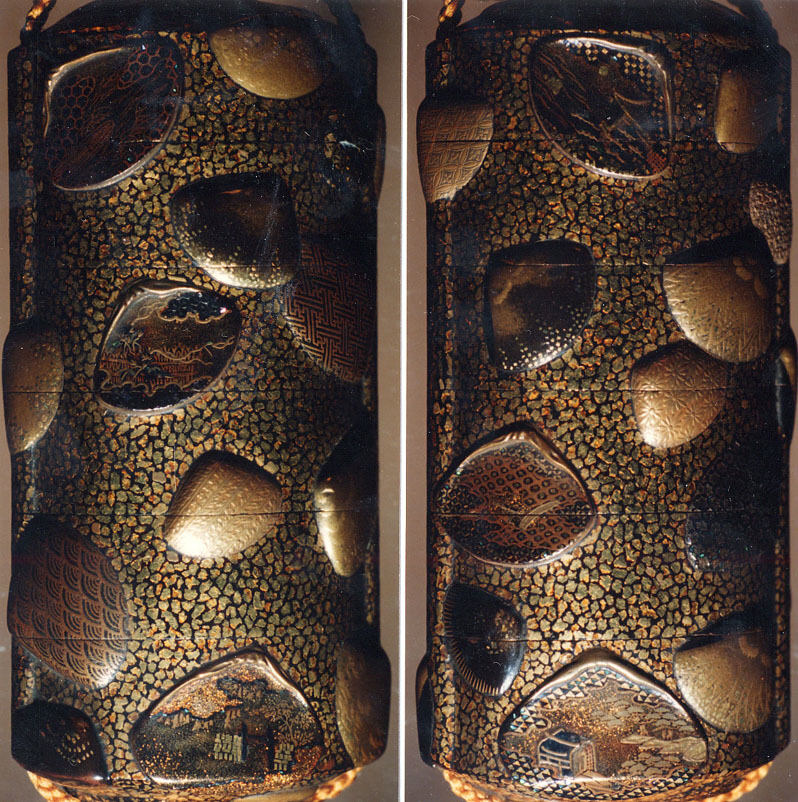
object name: inrō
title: Case (Inrō) with Design of Shells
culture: japanese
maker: tōyō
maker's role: artist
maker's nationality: japanese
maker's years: 1764-1771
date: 1801-1900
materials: gold, lacquer, silver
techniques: fundame, hiramakie, roiro, maki-e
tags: shells